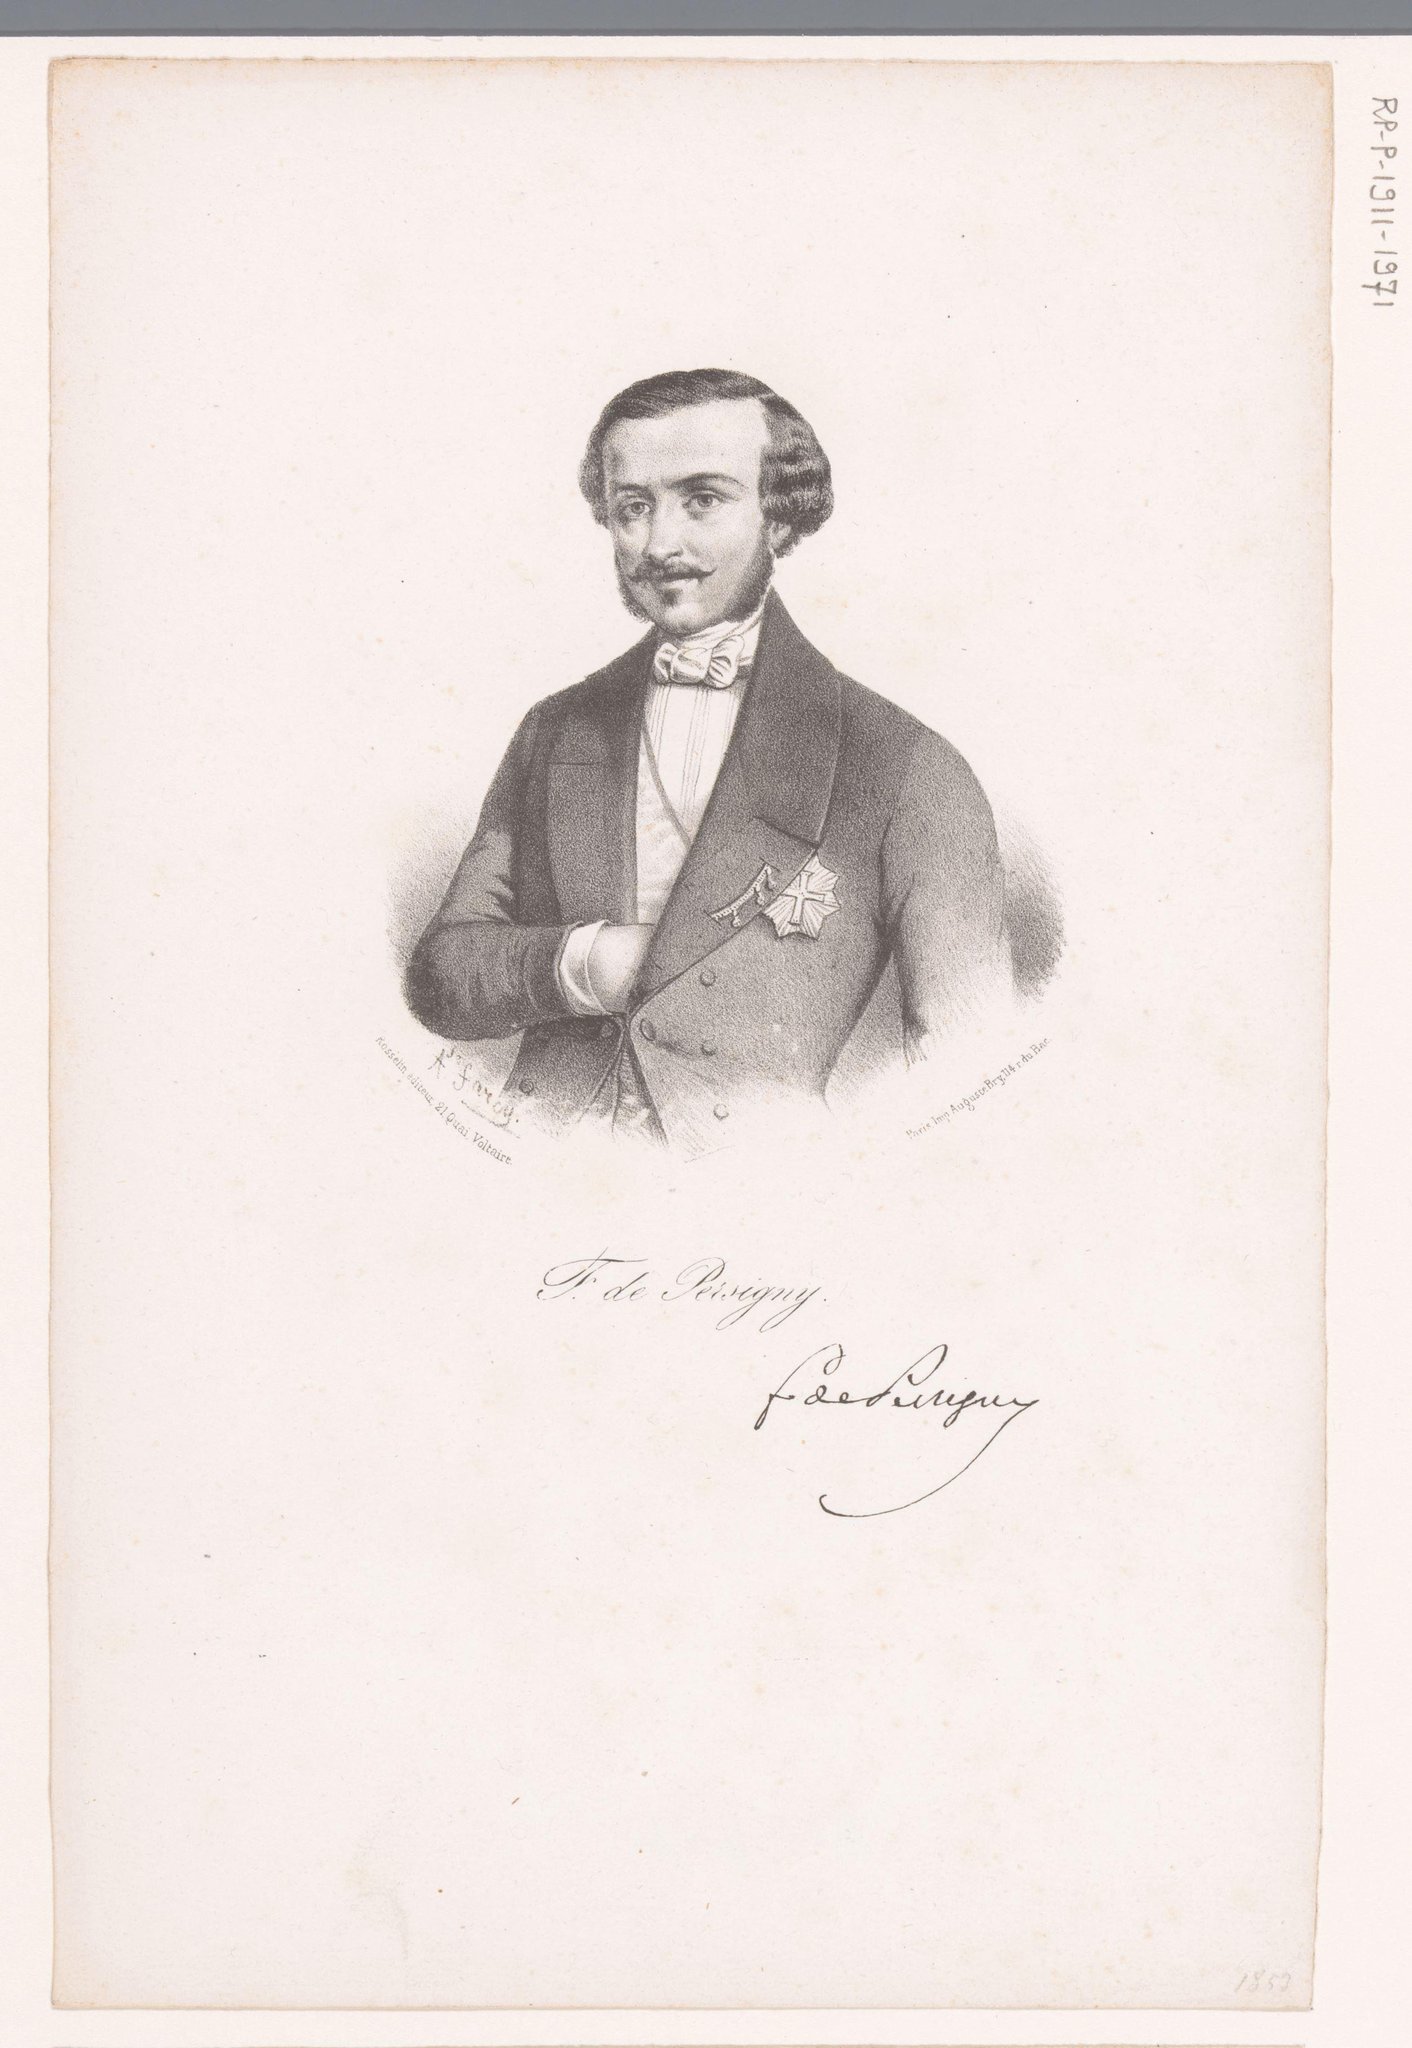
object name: print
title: Portret van Victor de Persigny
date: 1852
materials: paper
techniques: lithograph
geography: paris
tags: politician, historical persons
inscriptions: collector's mark: Lugt 2228a